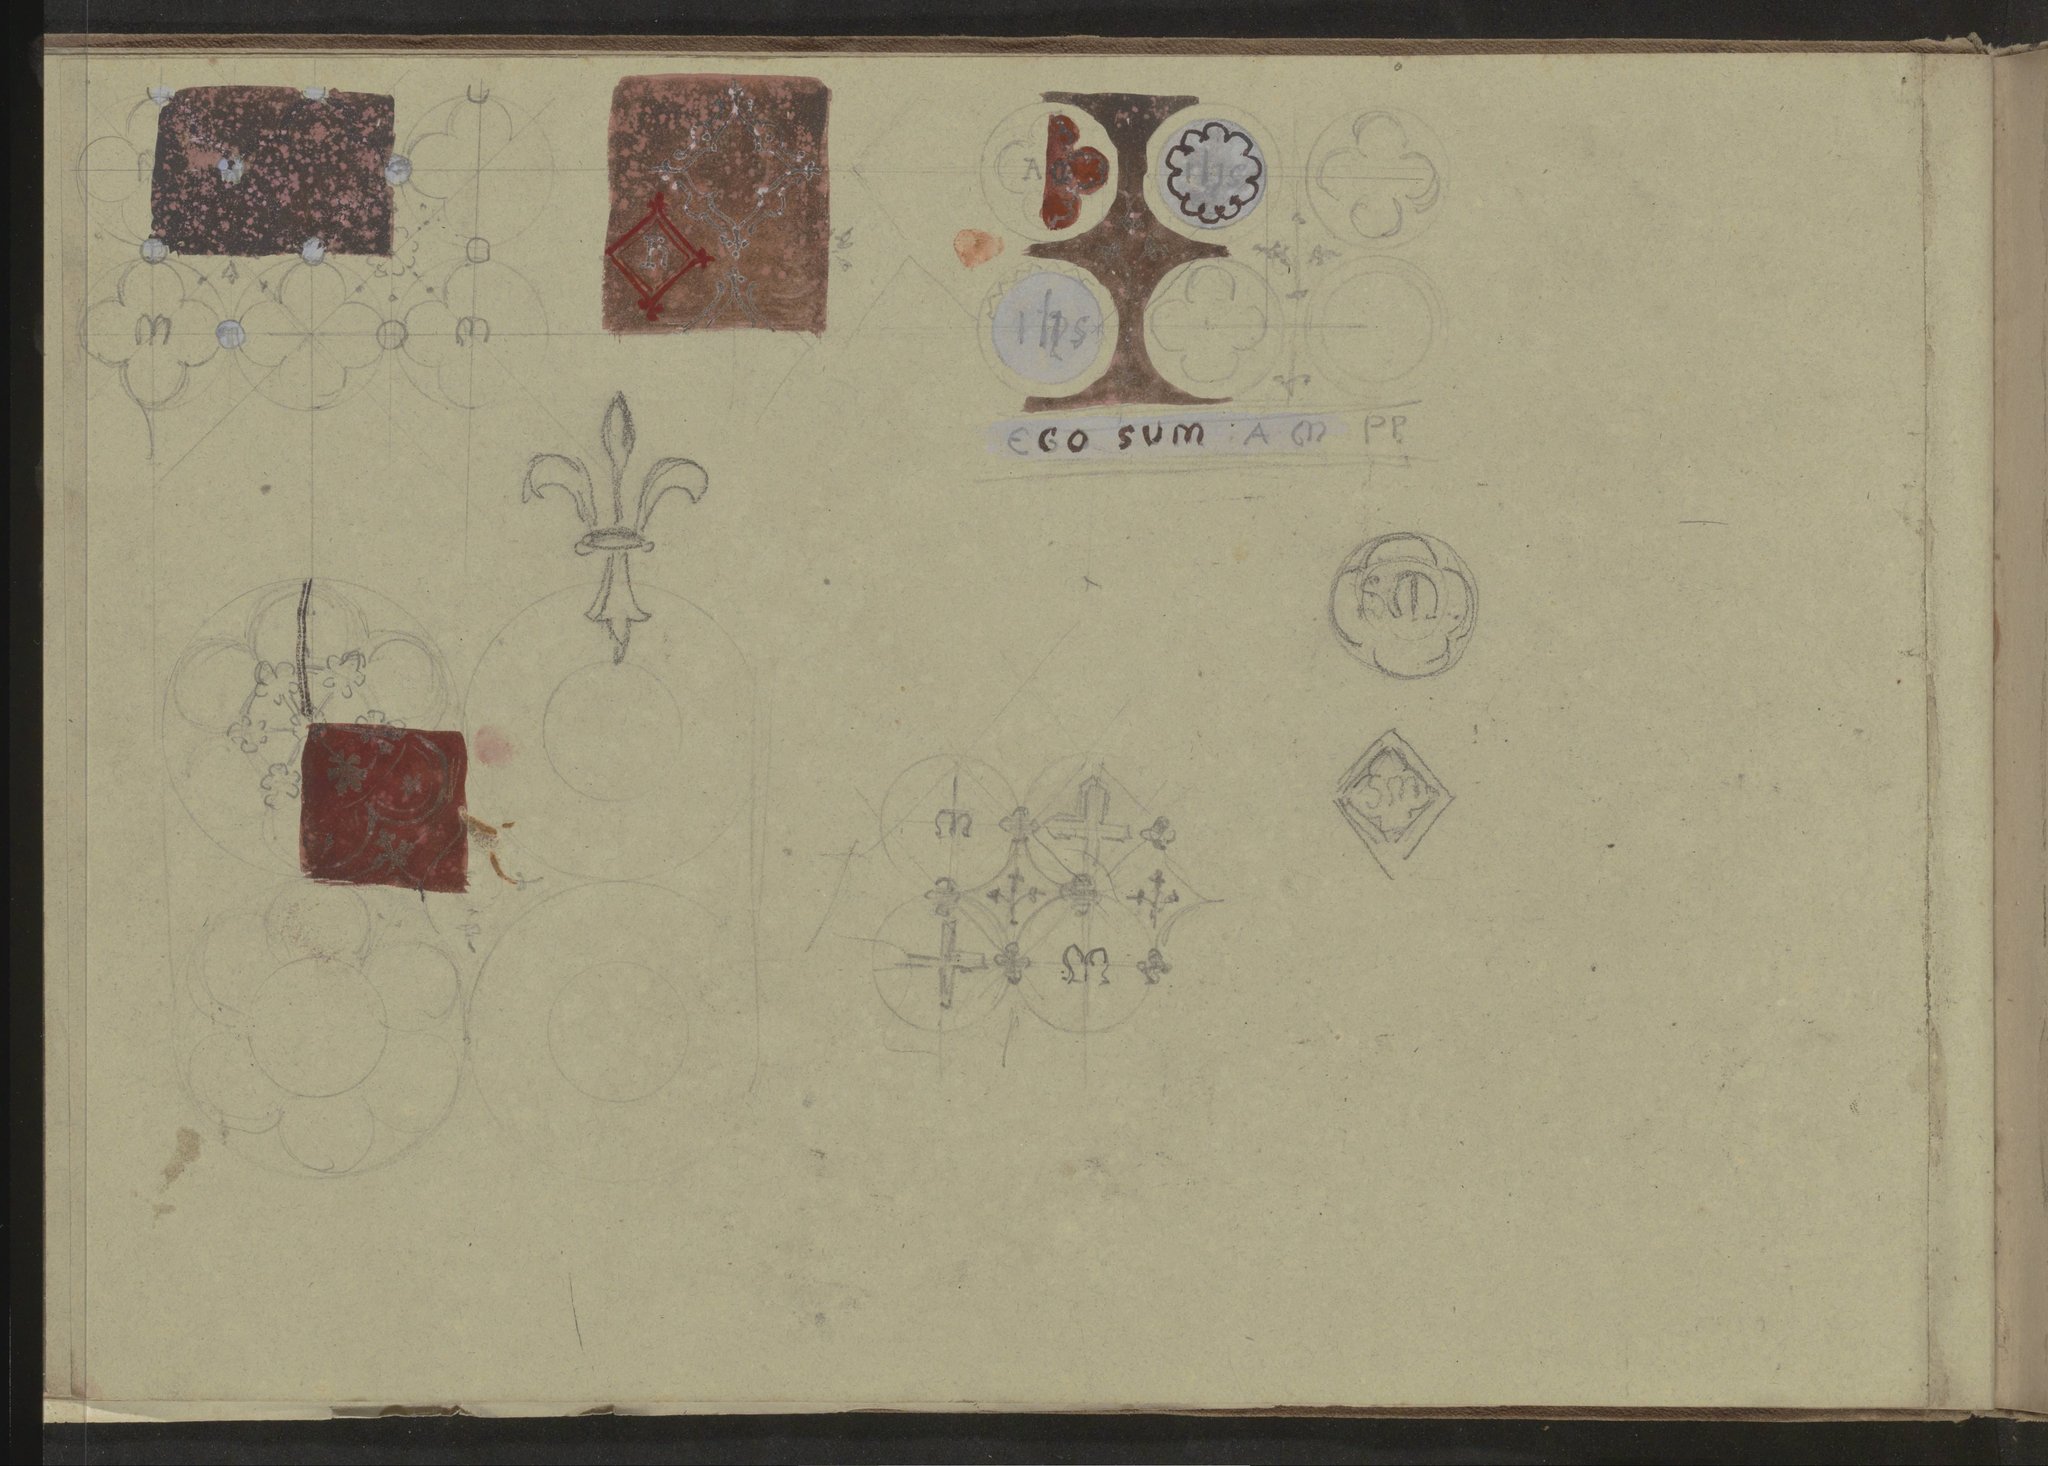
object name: sketchbook leaf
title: Ornamenten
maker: pierre joseph hubert cuypers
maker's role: draughtsman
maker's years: 1827-1921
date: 1837-1921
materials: paper, pencil, watercolor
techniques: brush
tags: foliage, tendrils, branches ~ ornament, flowers ~ ornament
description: Onder andere fleur-de-lys en vierpasmotieven. Blad 10 verso uit een schetsboek met 23 bladen.